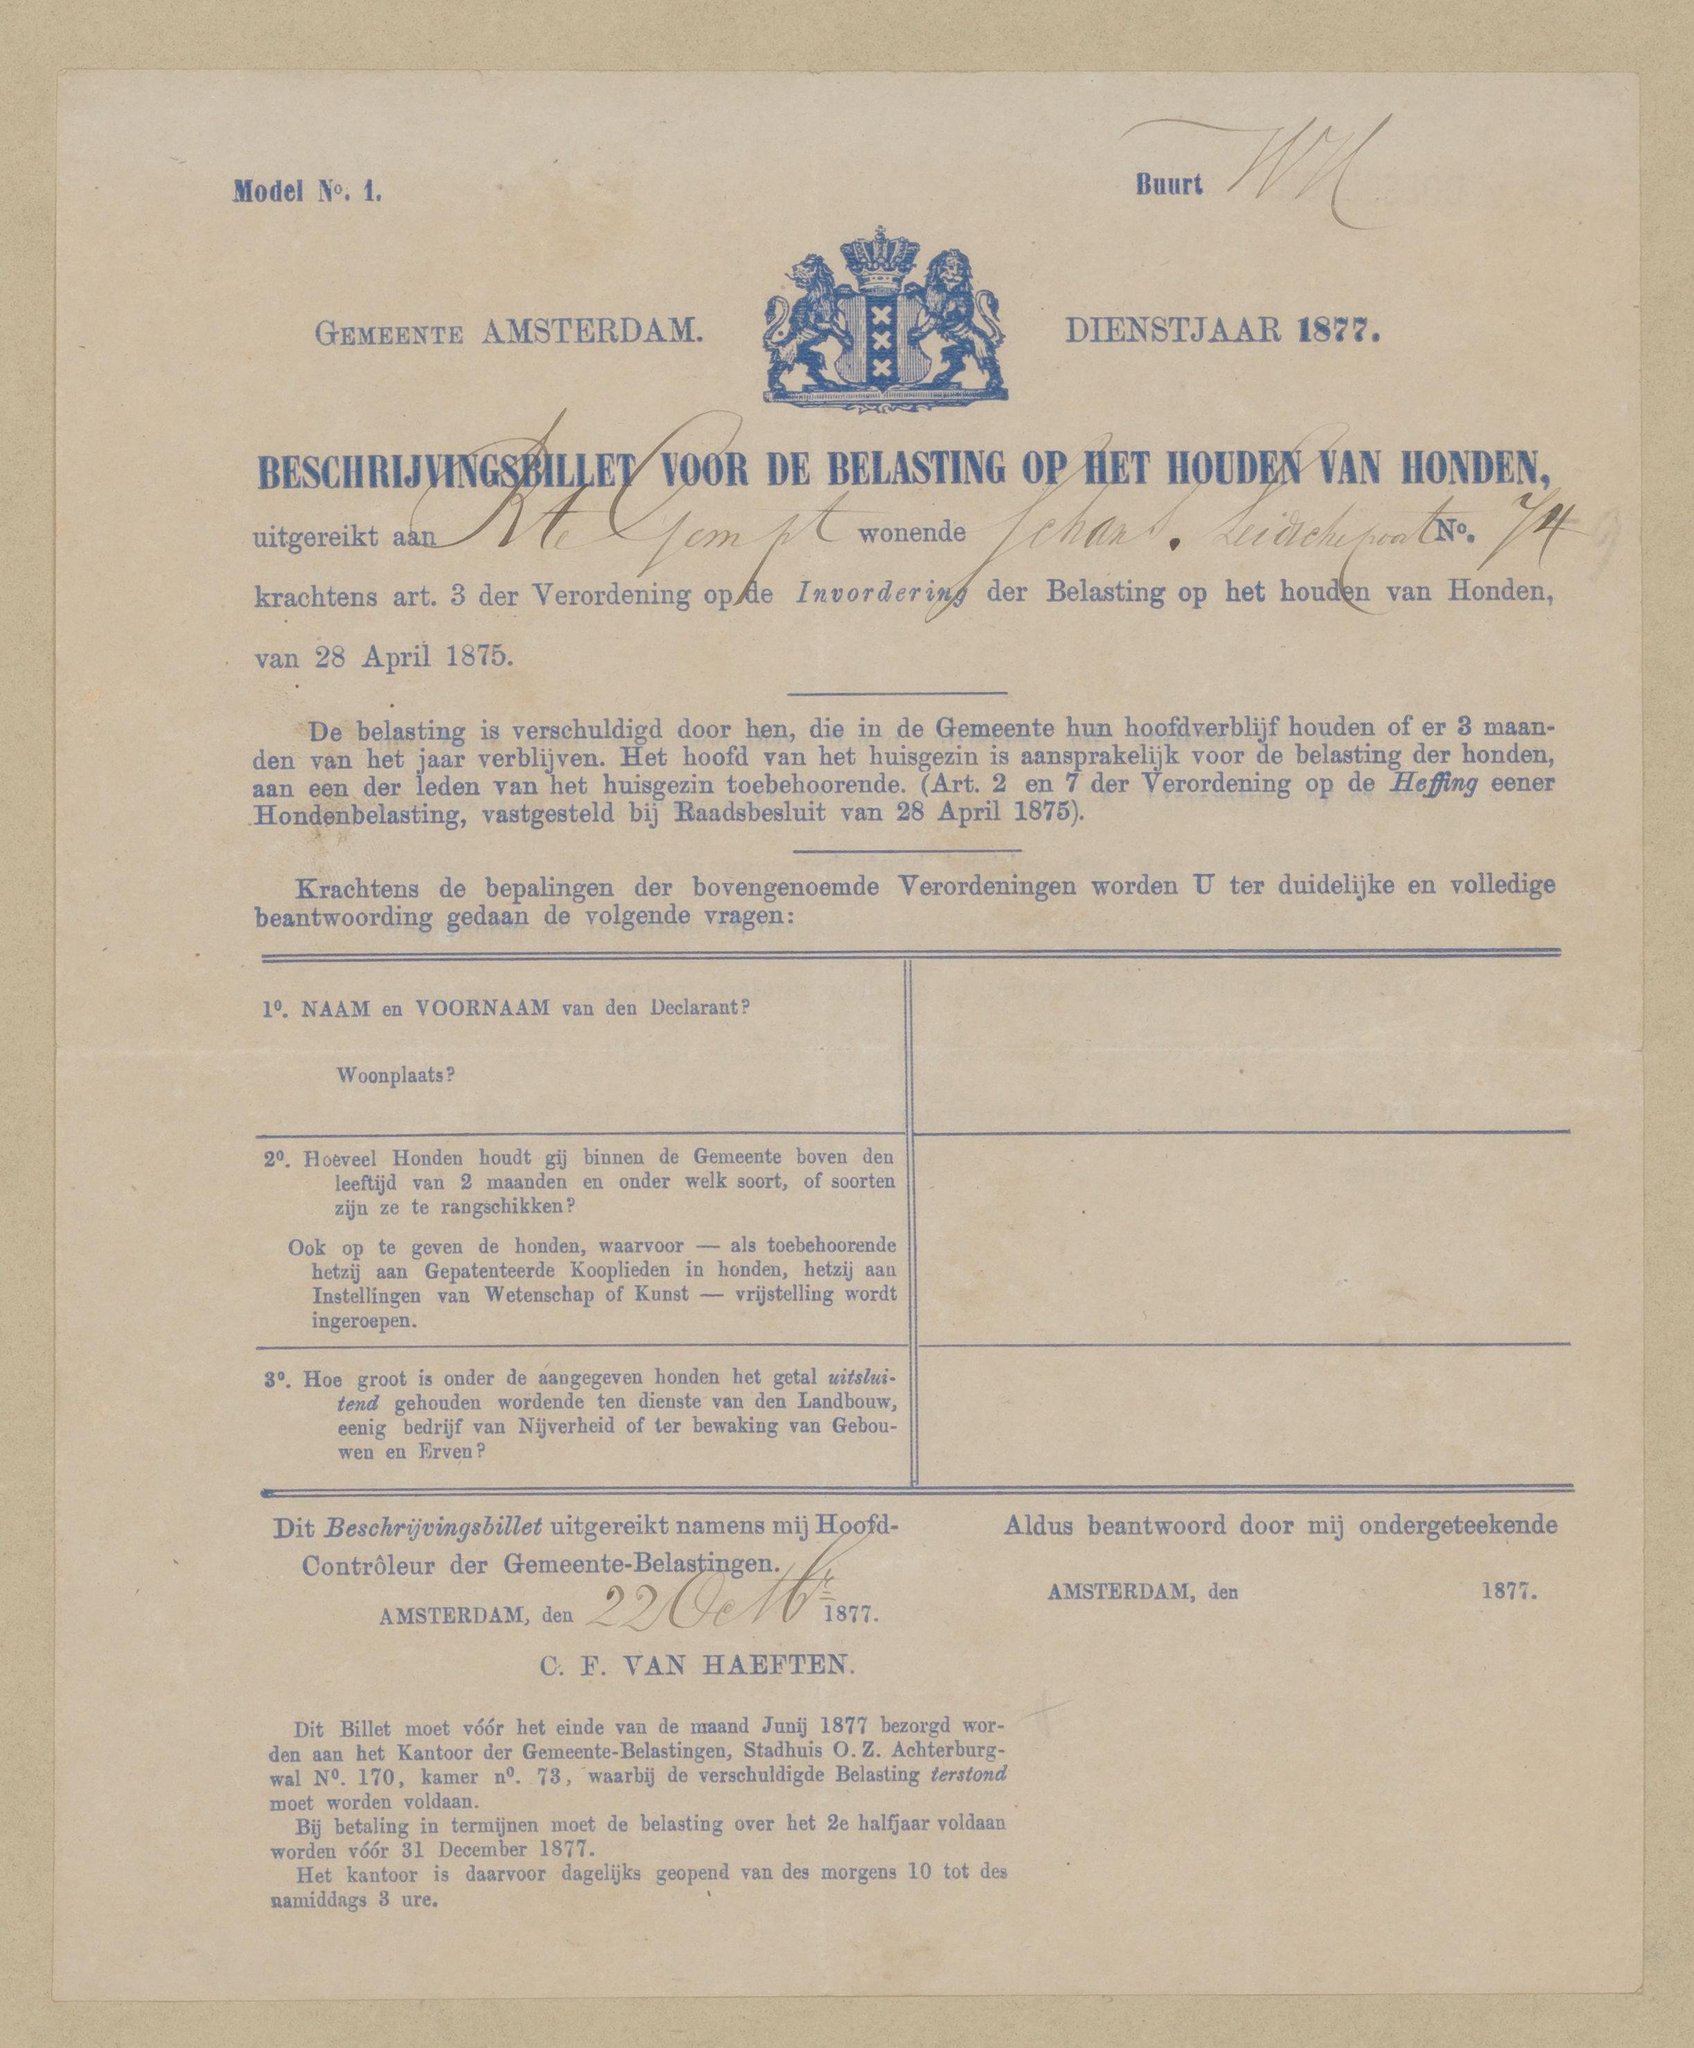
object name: document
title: Beschrijvingsbillet voor de belasting op het houden van honden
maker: charles felix van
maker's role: amateurschilder, commissaris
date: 1877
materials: ink, paper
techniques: letterpress printing, pen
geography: amsterdam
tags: amsterdam, painter, draughtsman, bernard te gempt, tax collection, tax payment, financial administration ~ taxes, municipal government, dog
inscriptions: collector's mark: Lugt 1641b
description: Onderwerpsrubriek binnen de Atlas Amsterdam: Belastingen.